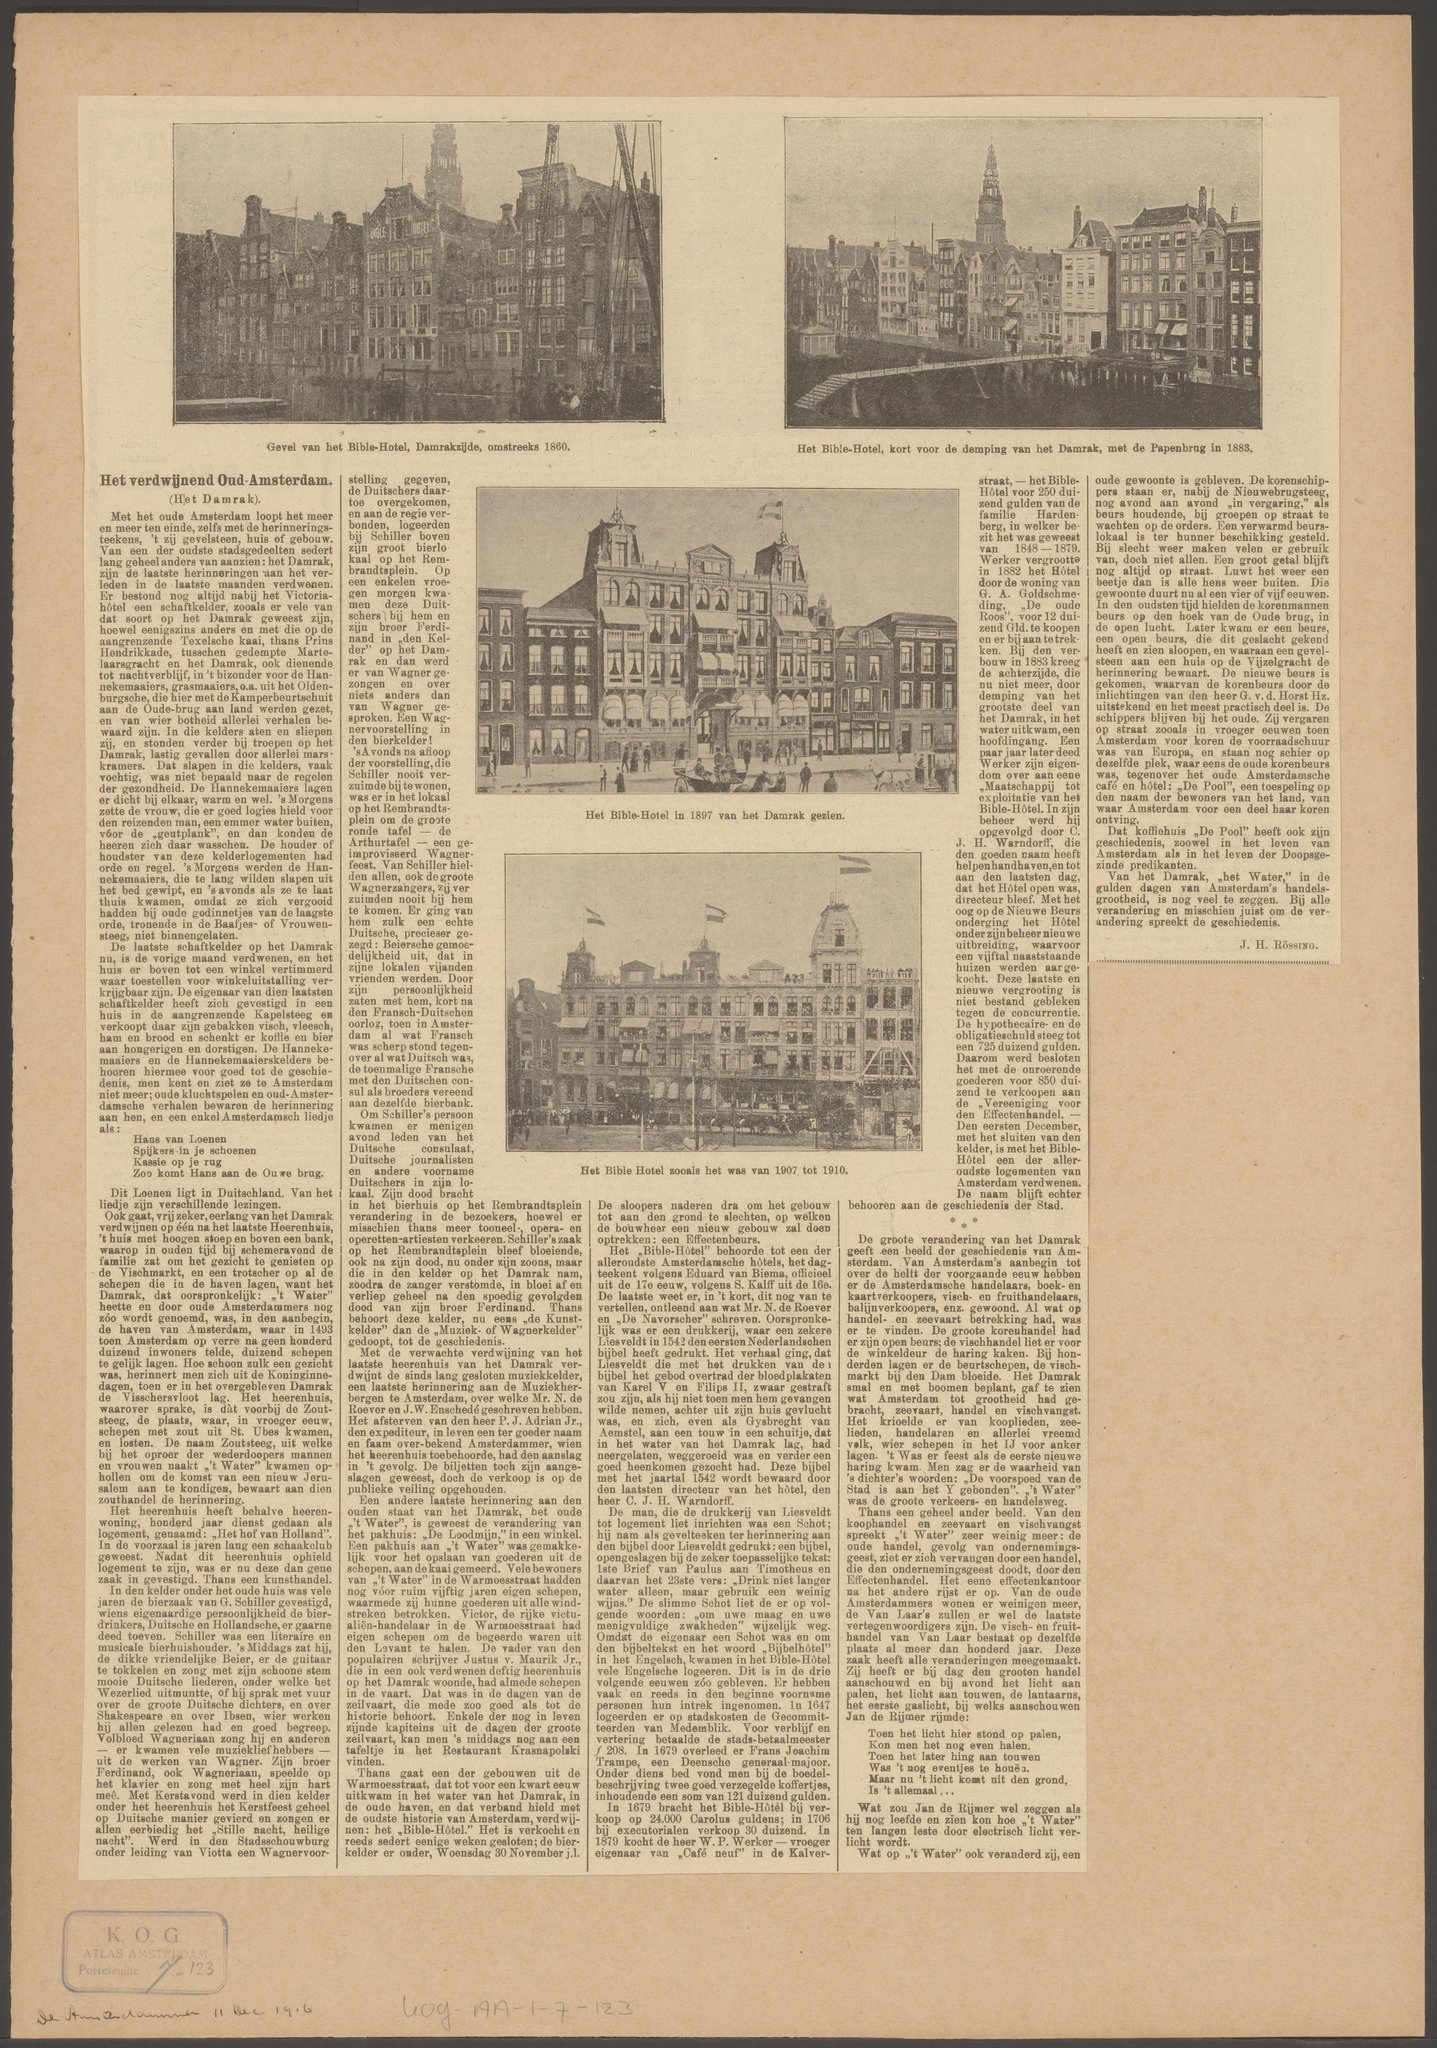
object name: newspaper clipping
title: Tekst over de geschiedenis van het Damrak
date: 1916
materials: paper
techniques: letterpress printing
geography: amsterdam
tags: city-view in general; 'veduta', façade (of house or building)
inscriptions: collector's mark: ‘7’ Lugt 1641b, name: ‘J.H. Rössing’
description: Onderwerpsrubriek binnen de Atlas Amsterdam: Damrak, Damstraat, Doelensluis, Doelenstraat (Nieuwe), Driehoekstraat, Droogbak, Duvelshoek, Dijkstraat en Korte -.